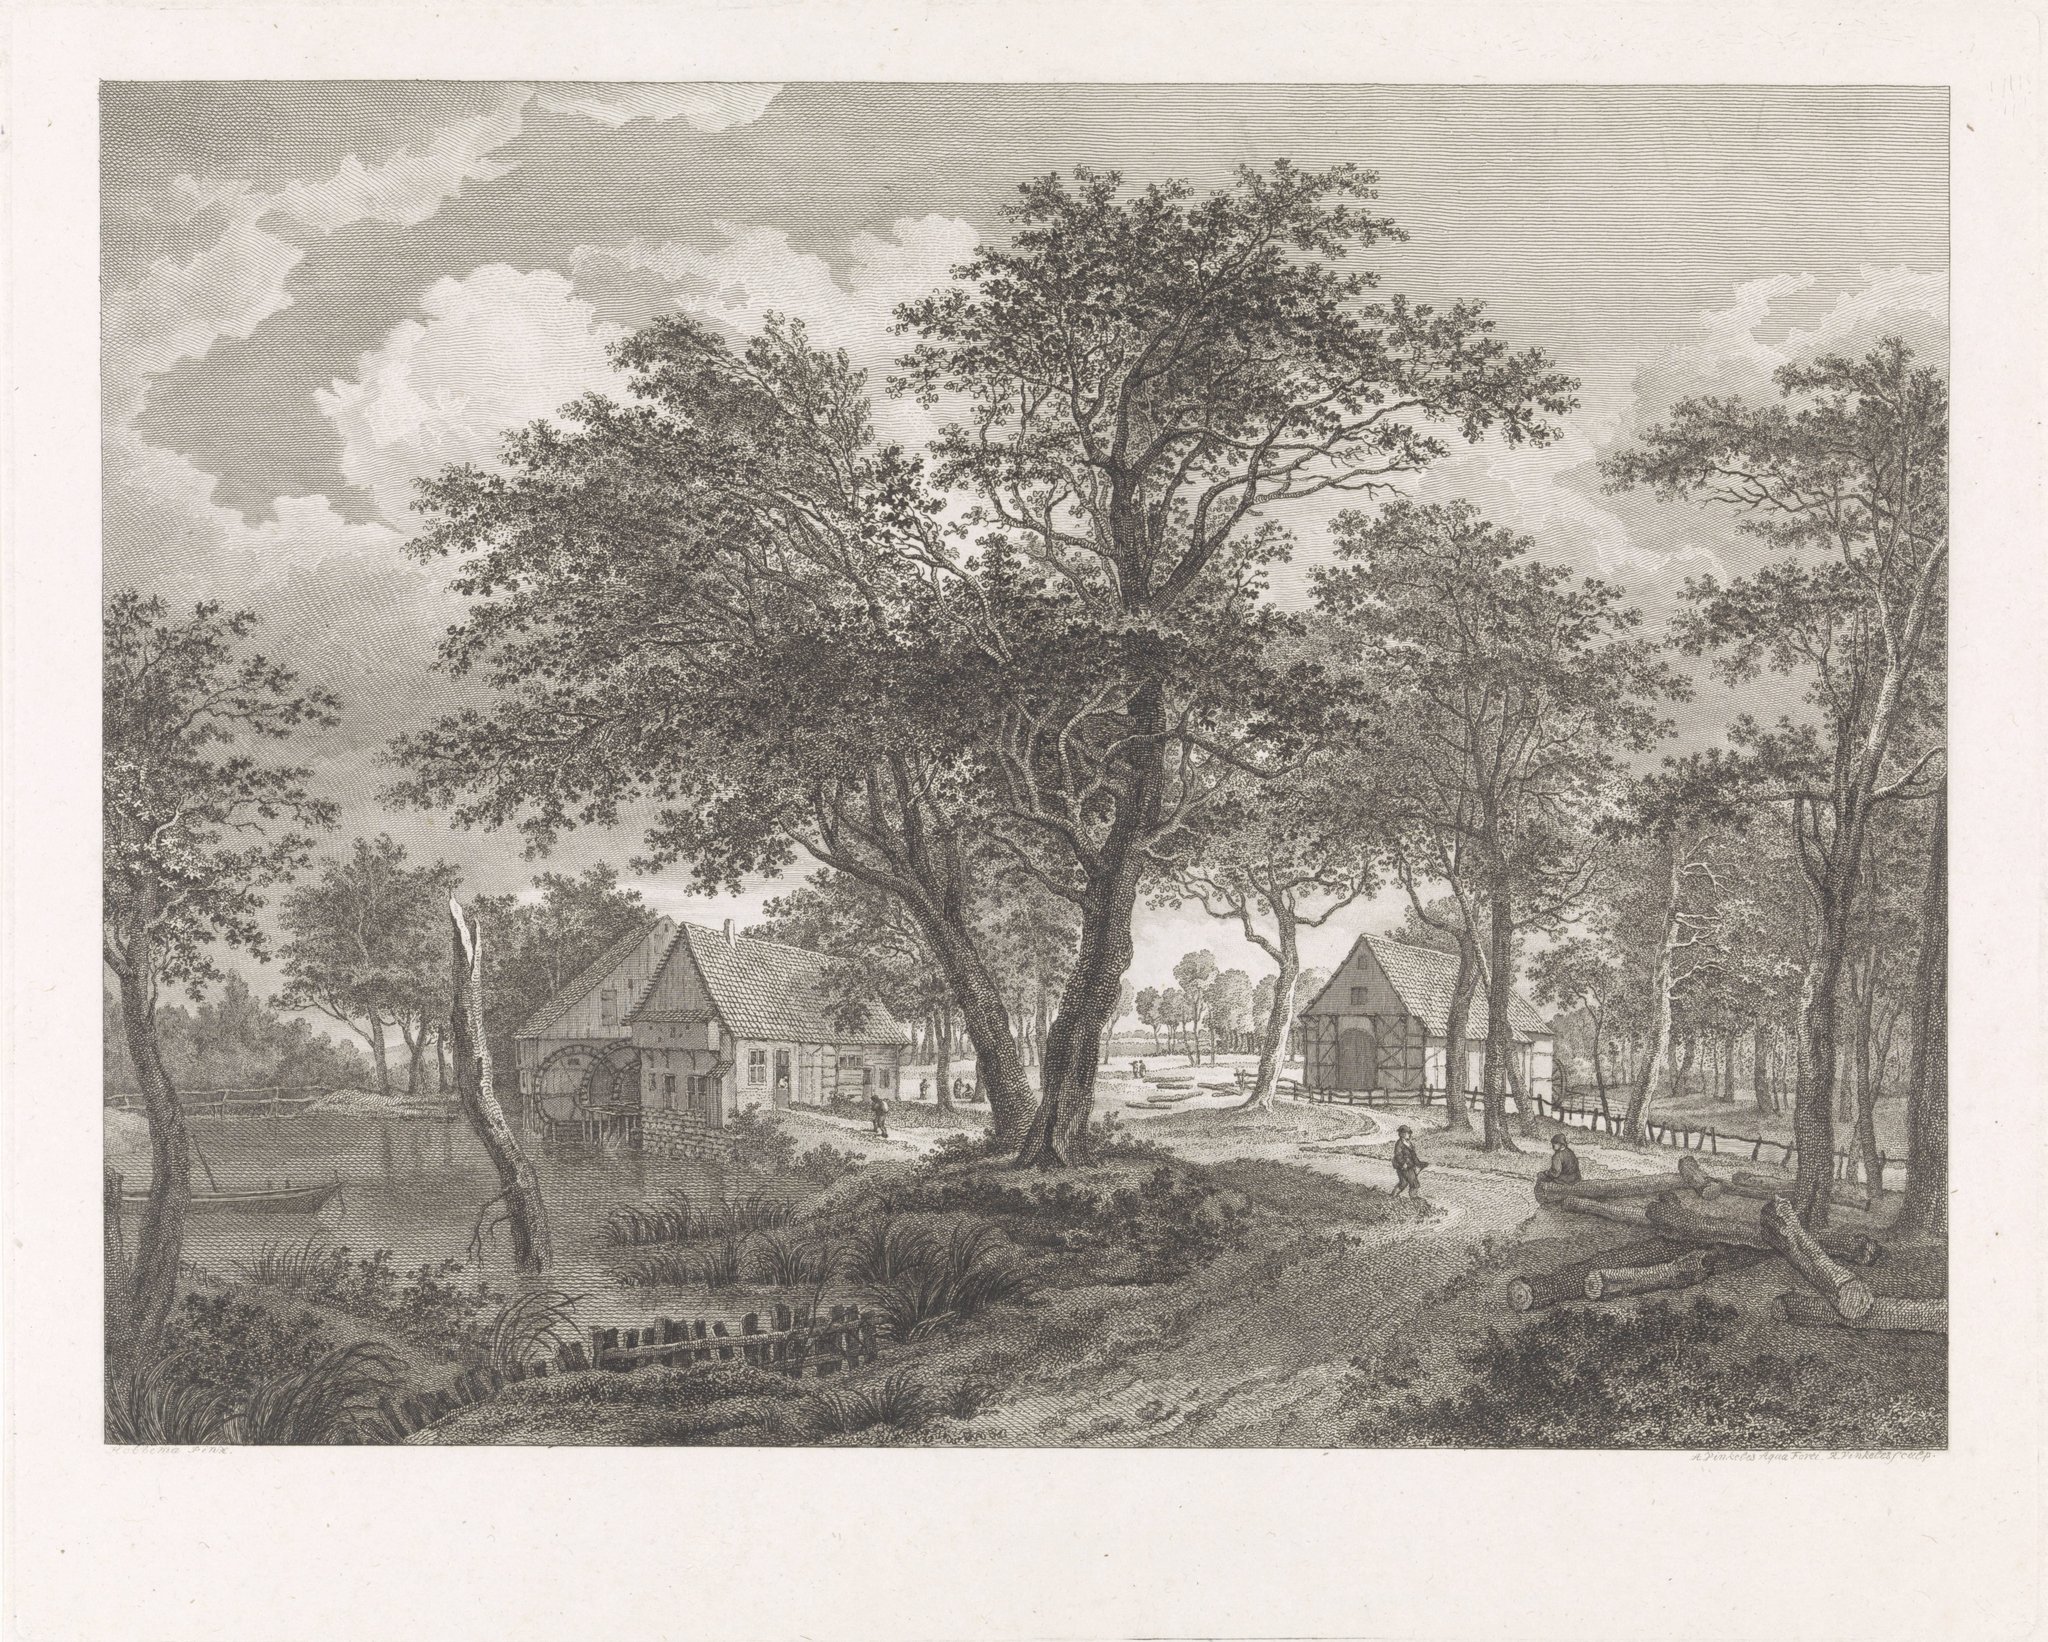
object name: print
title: Landschap met watermolen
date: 1800-1864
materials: paper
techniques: engraving, etching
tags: watermill in landscape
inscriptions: collector's mark: Lugt 2228